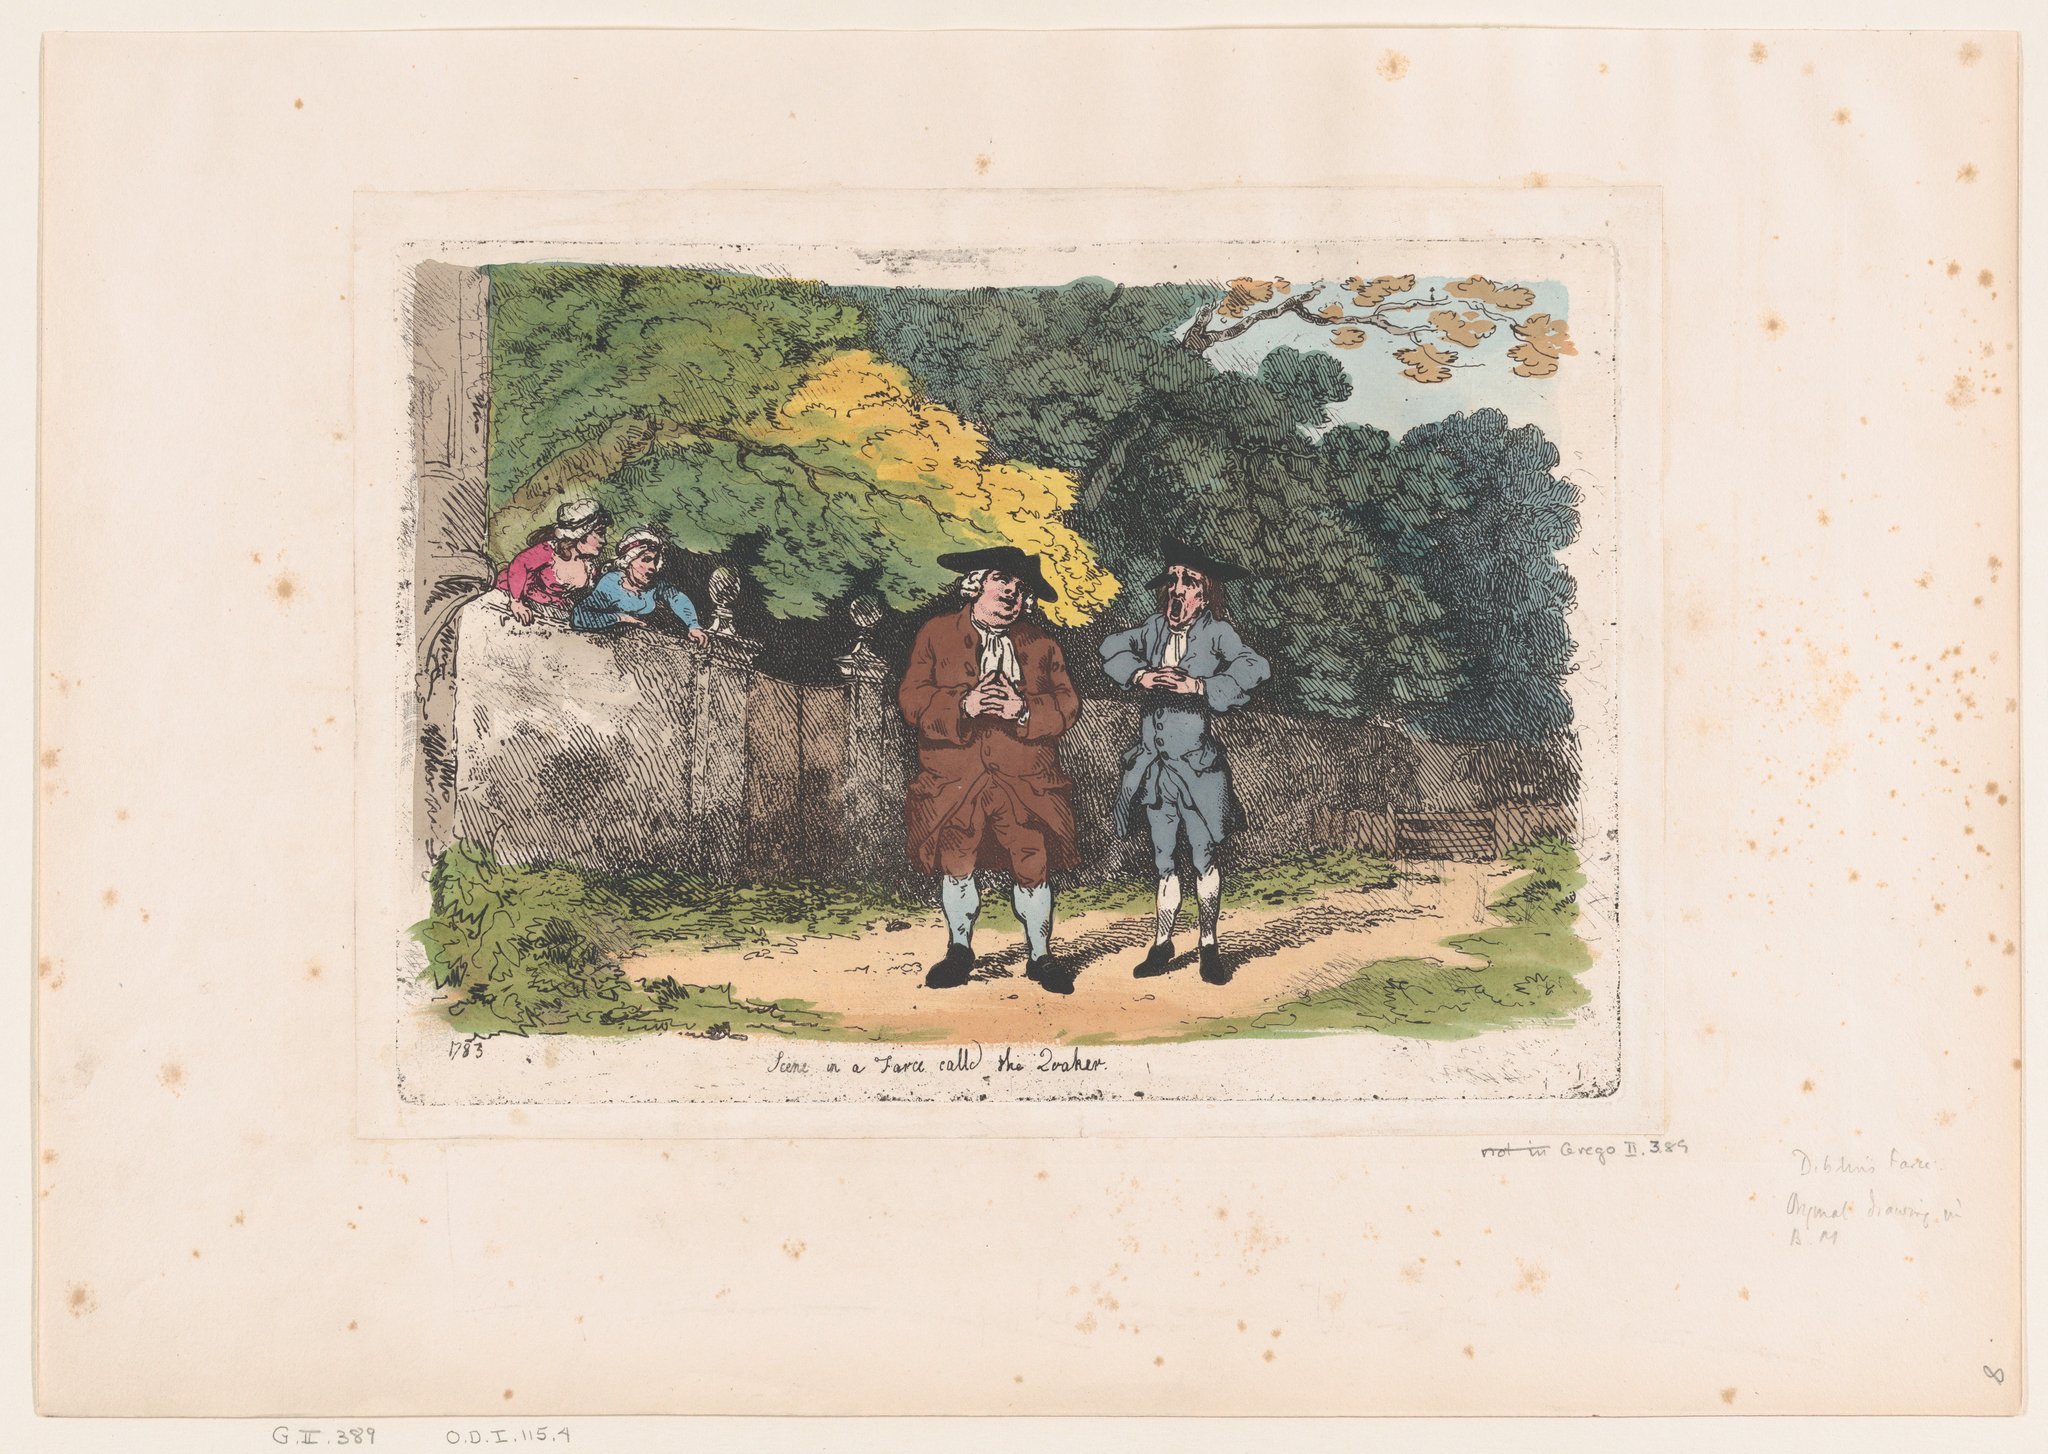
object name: print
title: Scene in a Farce called The Quaker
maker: thomas rowlandson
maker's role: artist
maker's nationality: british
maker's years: 1757-1827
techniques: etching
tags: performance,men,women